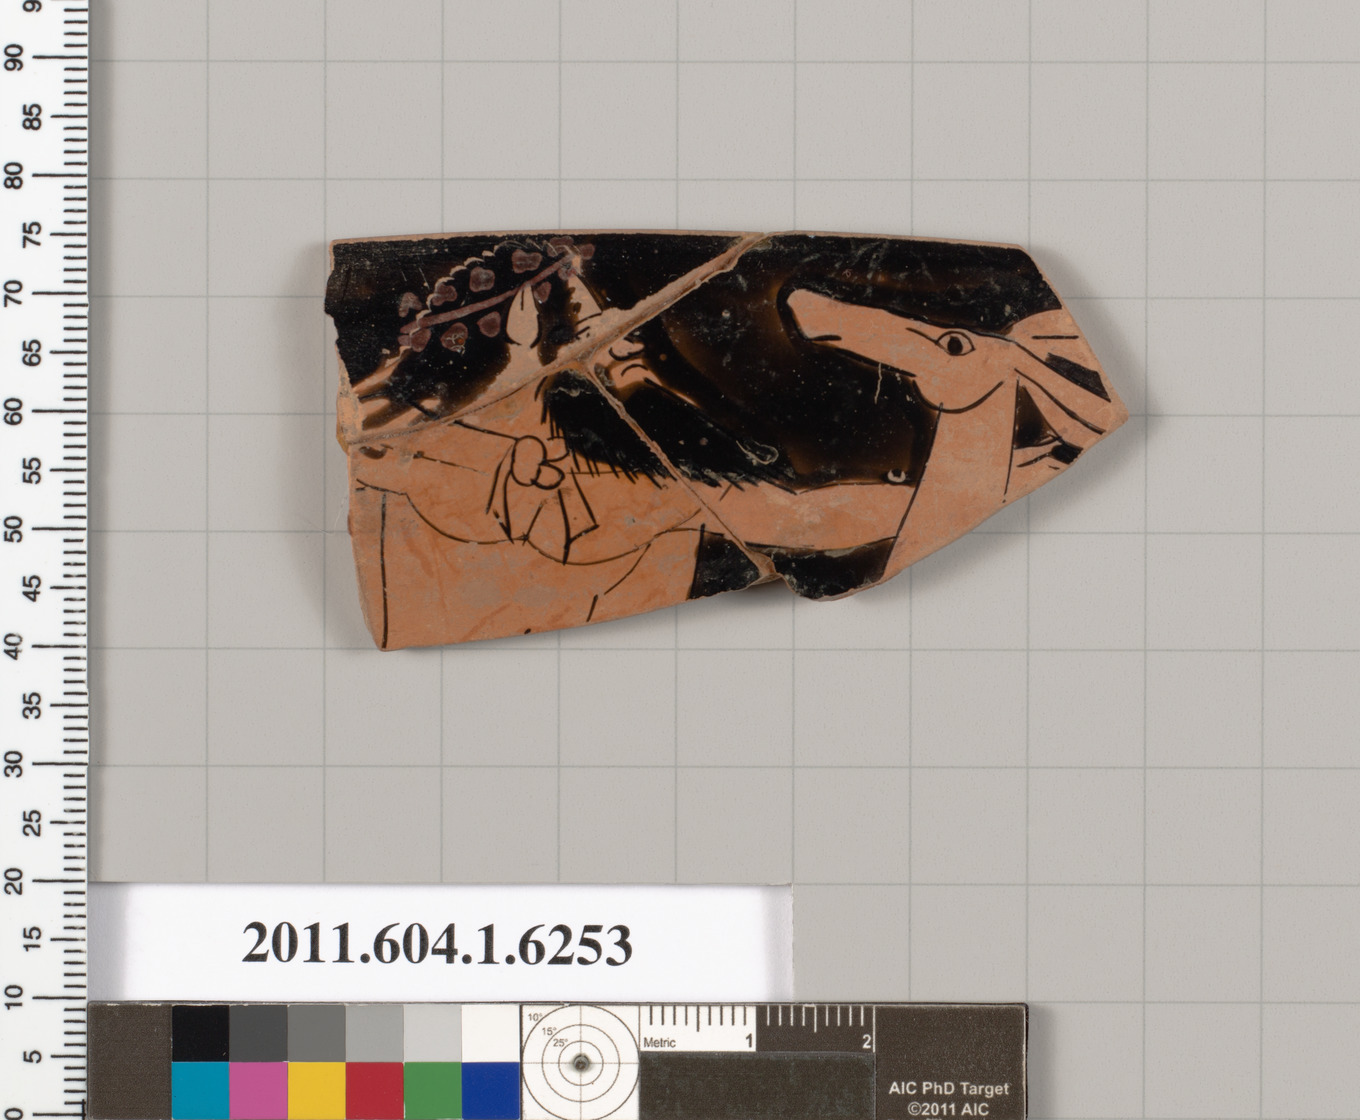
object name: kylix fragment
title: Terracotta rim fragment of a kylix (drinking cup)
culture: greek, attic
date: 500-480 BCE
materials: terracotta